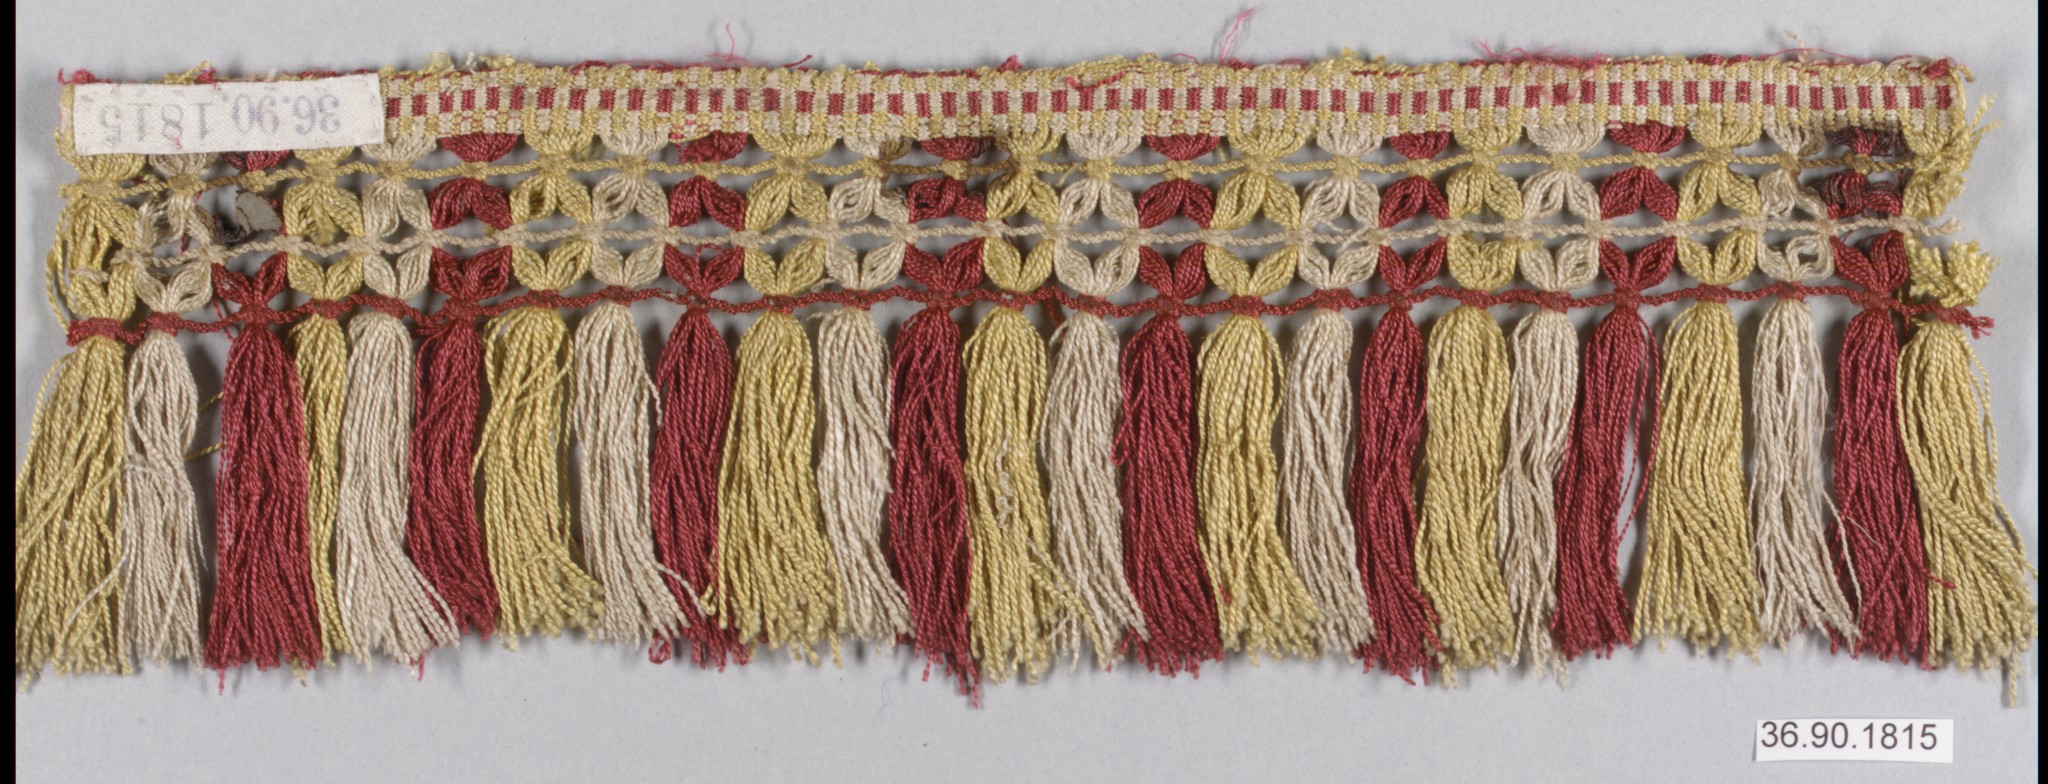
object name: fringe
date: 1767-1800